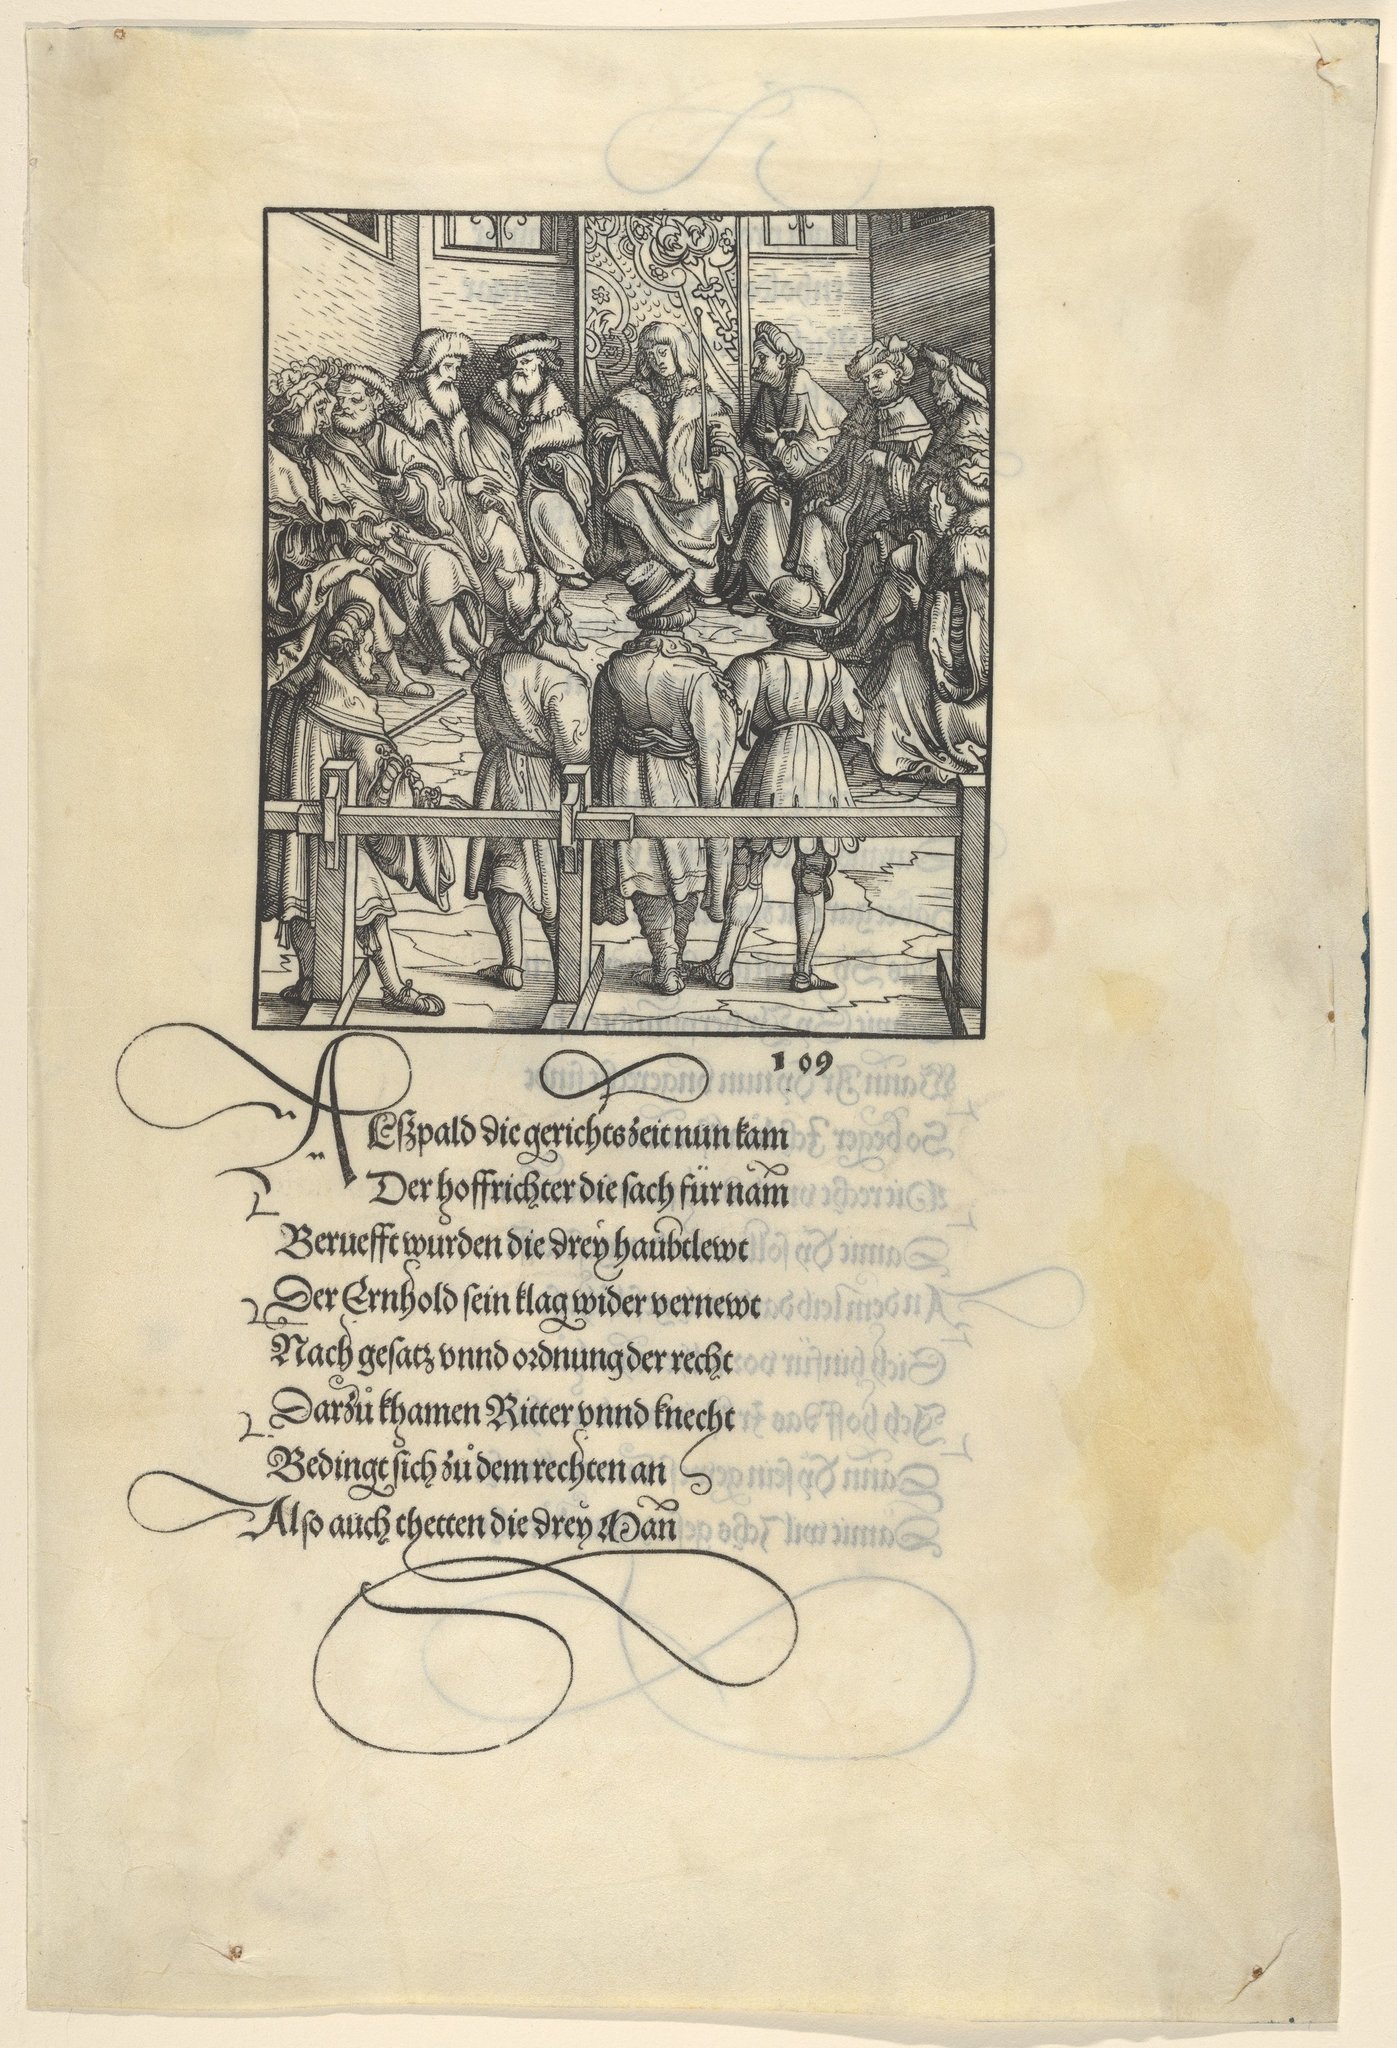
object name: print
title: Three Captains Brought Up for Judgment, from [Theuerdank] Die geuerlicheiten vnd einsteils der geschichten des loblichen streytparen vnd hochberümbten helds vnd Ritters herr Tewrdannckhs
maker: hans burgkmair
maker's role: artist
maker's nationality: german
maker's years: 1473-1531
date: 1517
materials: parchment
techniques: woodcut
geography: germany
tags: men,women